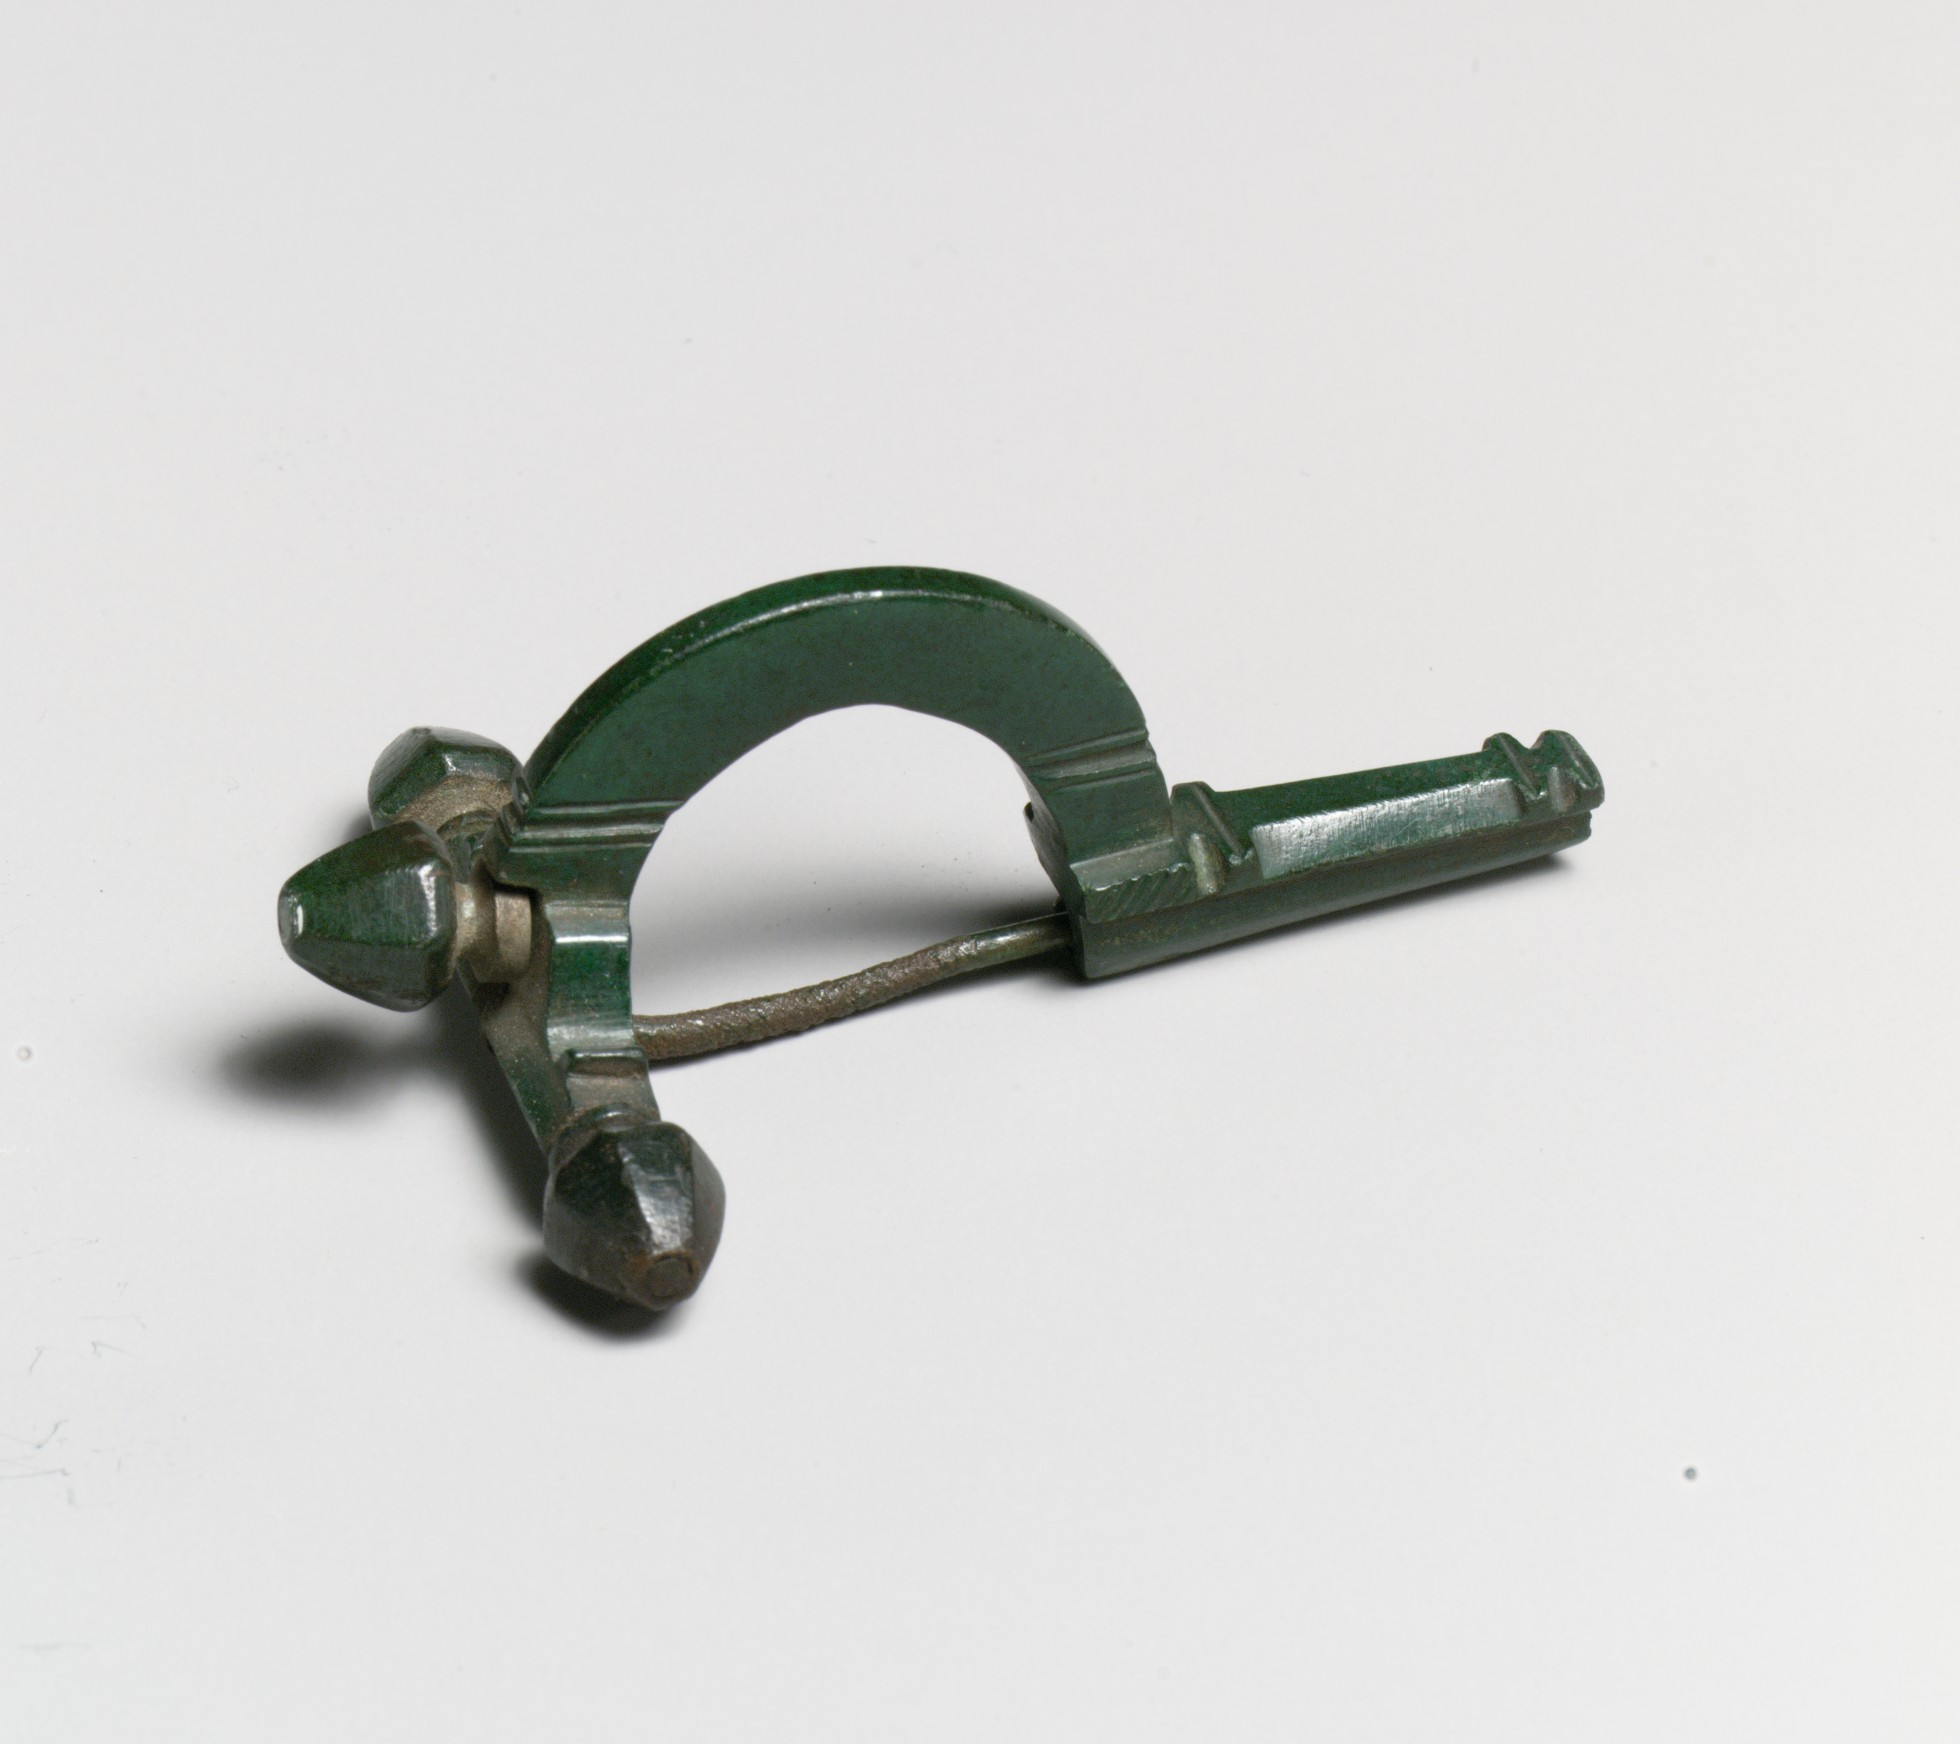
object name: fibula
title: Bronze crossbow fibula (brooch)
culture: roman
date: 301-400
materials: bronze